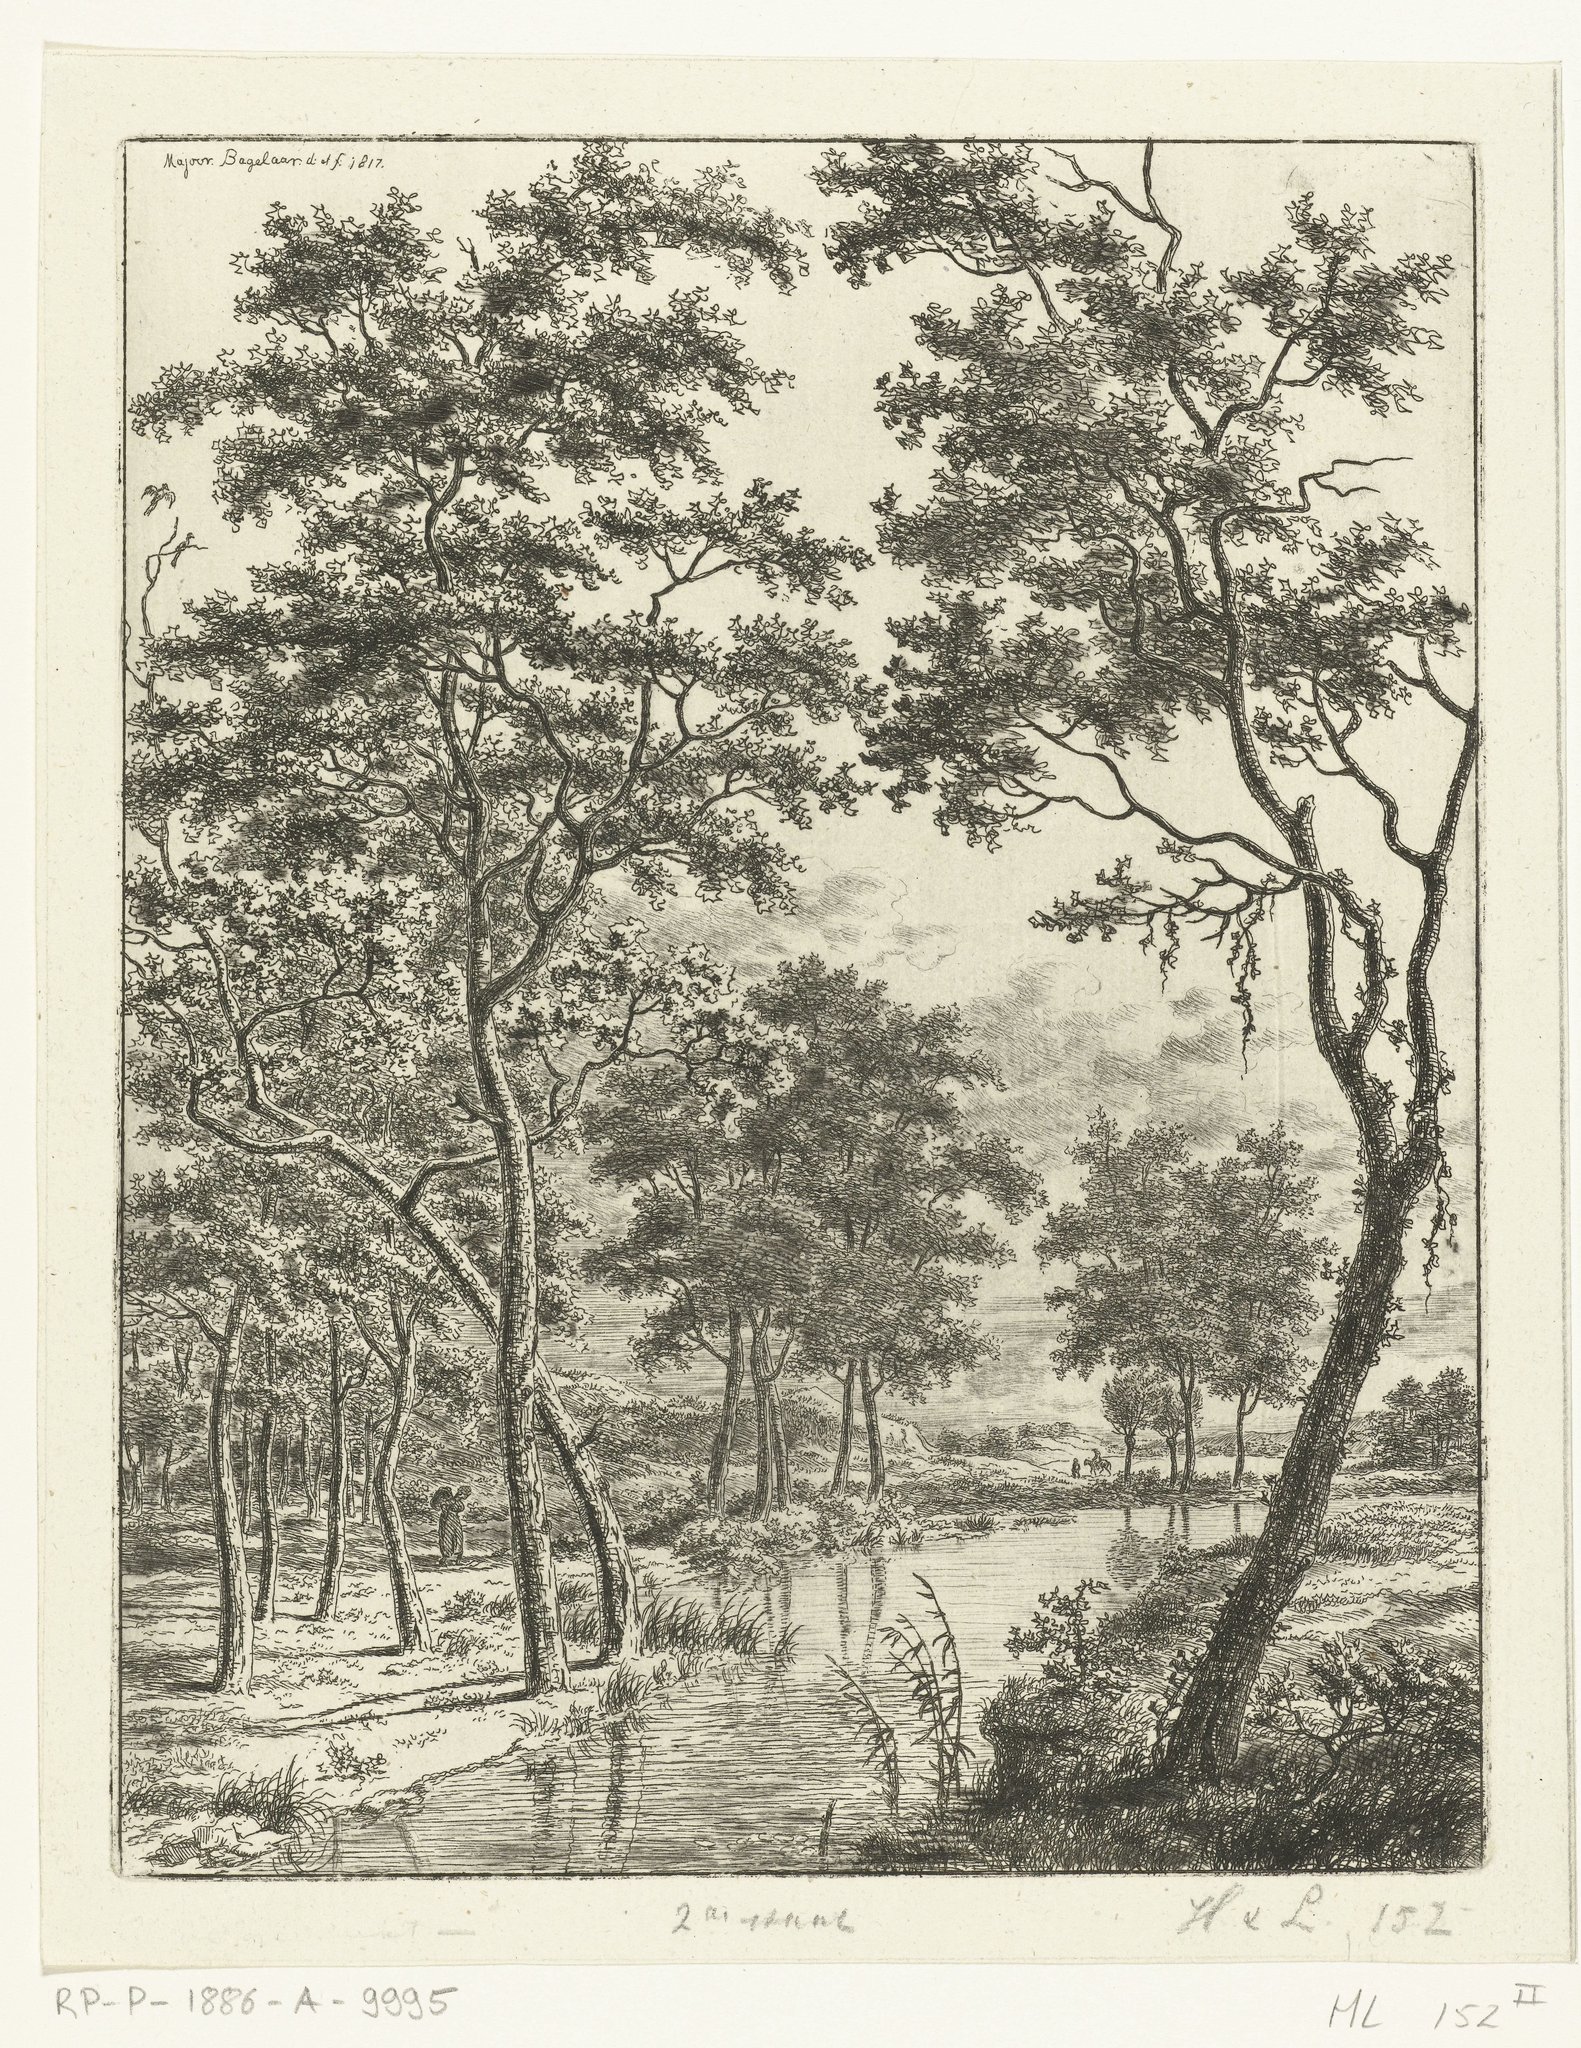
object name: print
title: Rivierlandschap met bomen, in de verte twee ruiters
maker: ernst willem jan bagelaar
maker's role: draughtsman, print maker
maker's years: 1775-1837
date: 1817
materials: paper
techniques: drypoint, etching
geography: netherlands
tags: herding, herdsman, herdswoman, shepherd, shepherdess, cowherd, etc., landscapes with waters, waterscapes, seascapes (in the temperate zone)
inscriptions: collector's mark: Lugt 2228